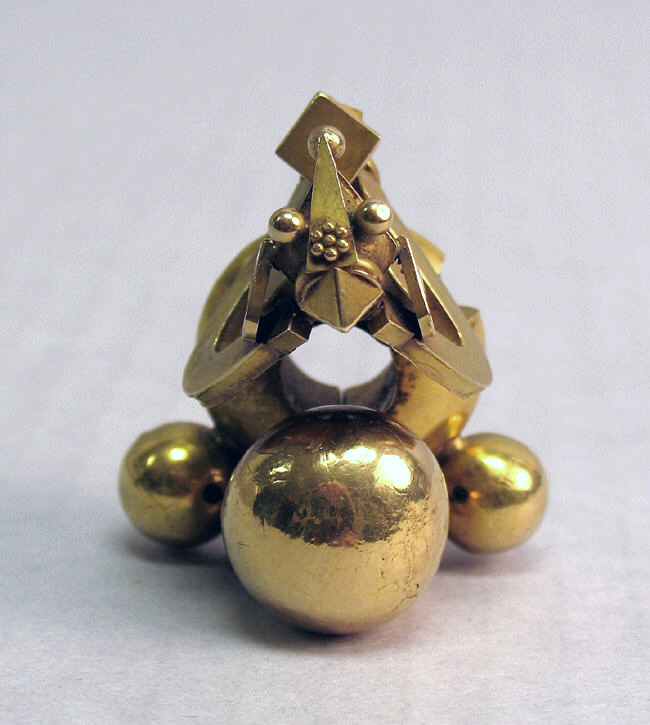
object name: earring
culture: indian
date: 1901-2000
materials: gold